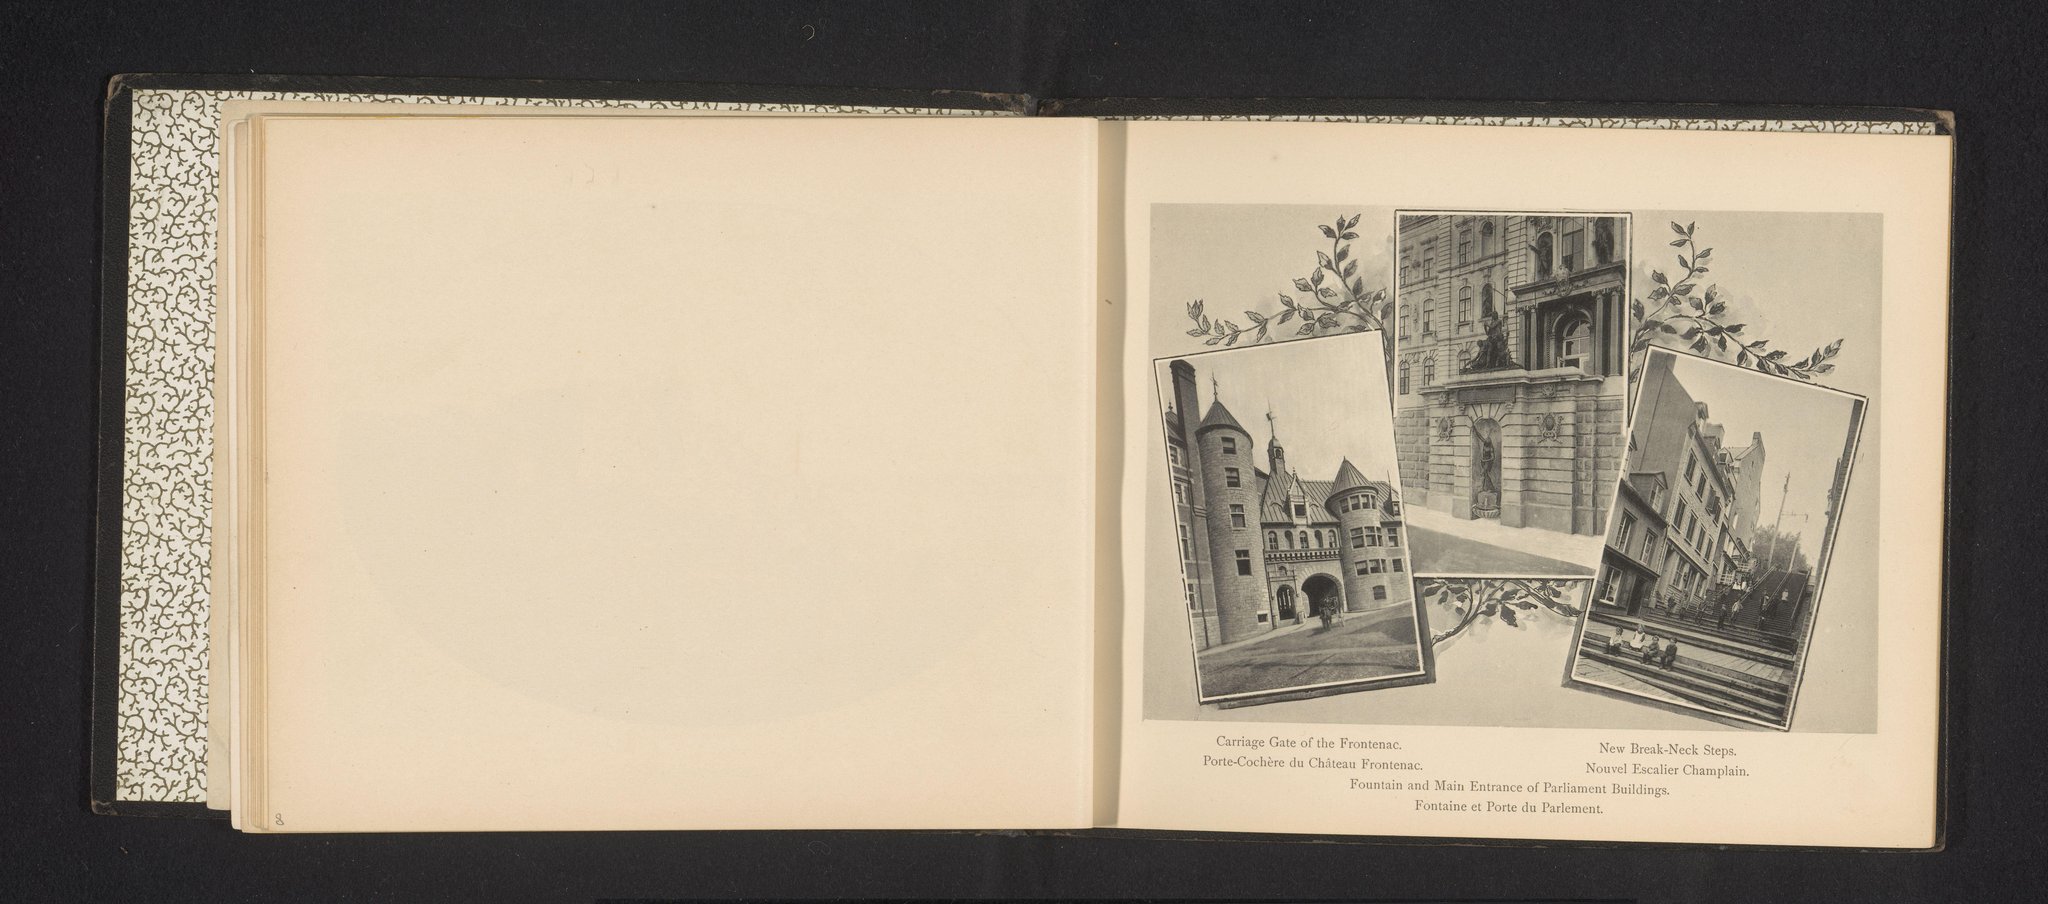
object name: photomechanical print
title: Fotomontage van drie straatgezichten in Québec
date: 1889-1894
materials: paper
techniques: photograph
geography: quebec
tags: castle, street, lower house, parliament, chamber, québec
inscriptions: inscription: ‘Carriage Gate of the Frontenac/ New Break-Neck Steps/ Fountain and Main Entrance of Paliament Buildings (...)’